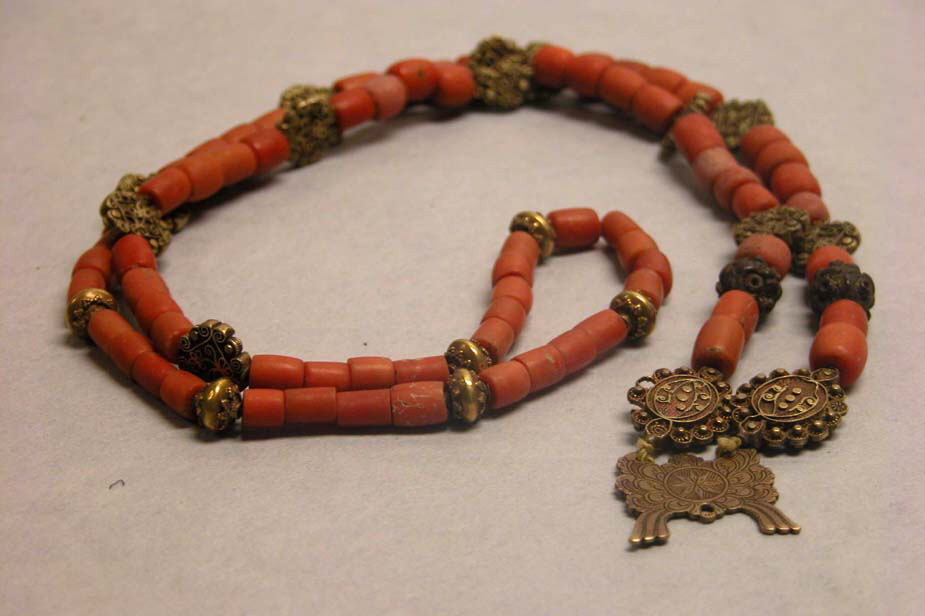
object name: necklace or rosary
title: Necklace or Rosary (?)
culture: filipino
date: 1601-1900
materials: coral, gold